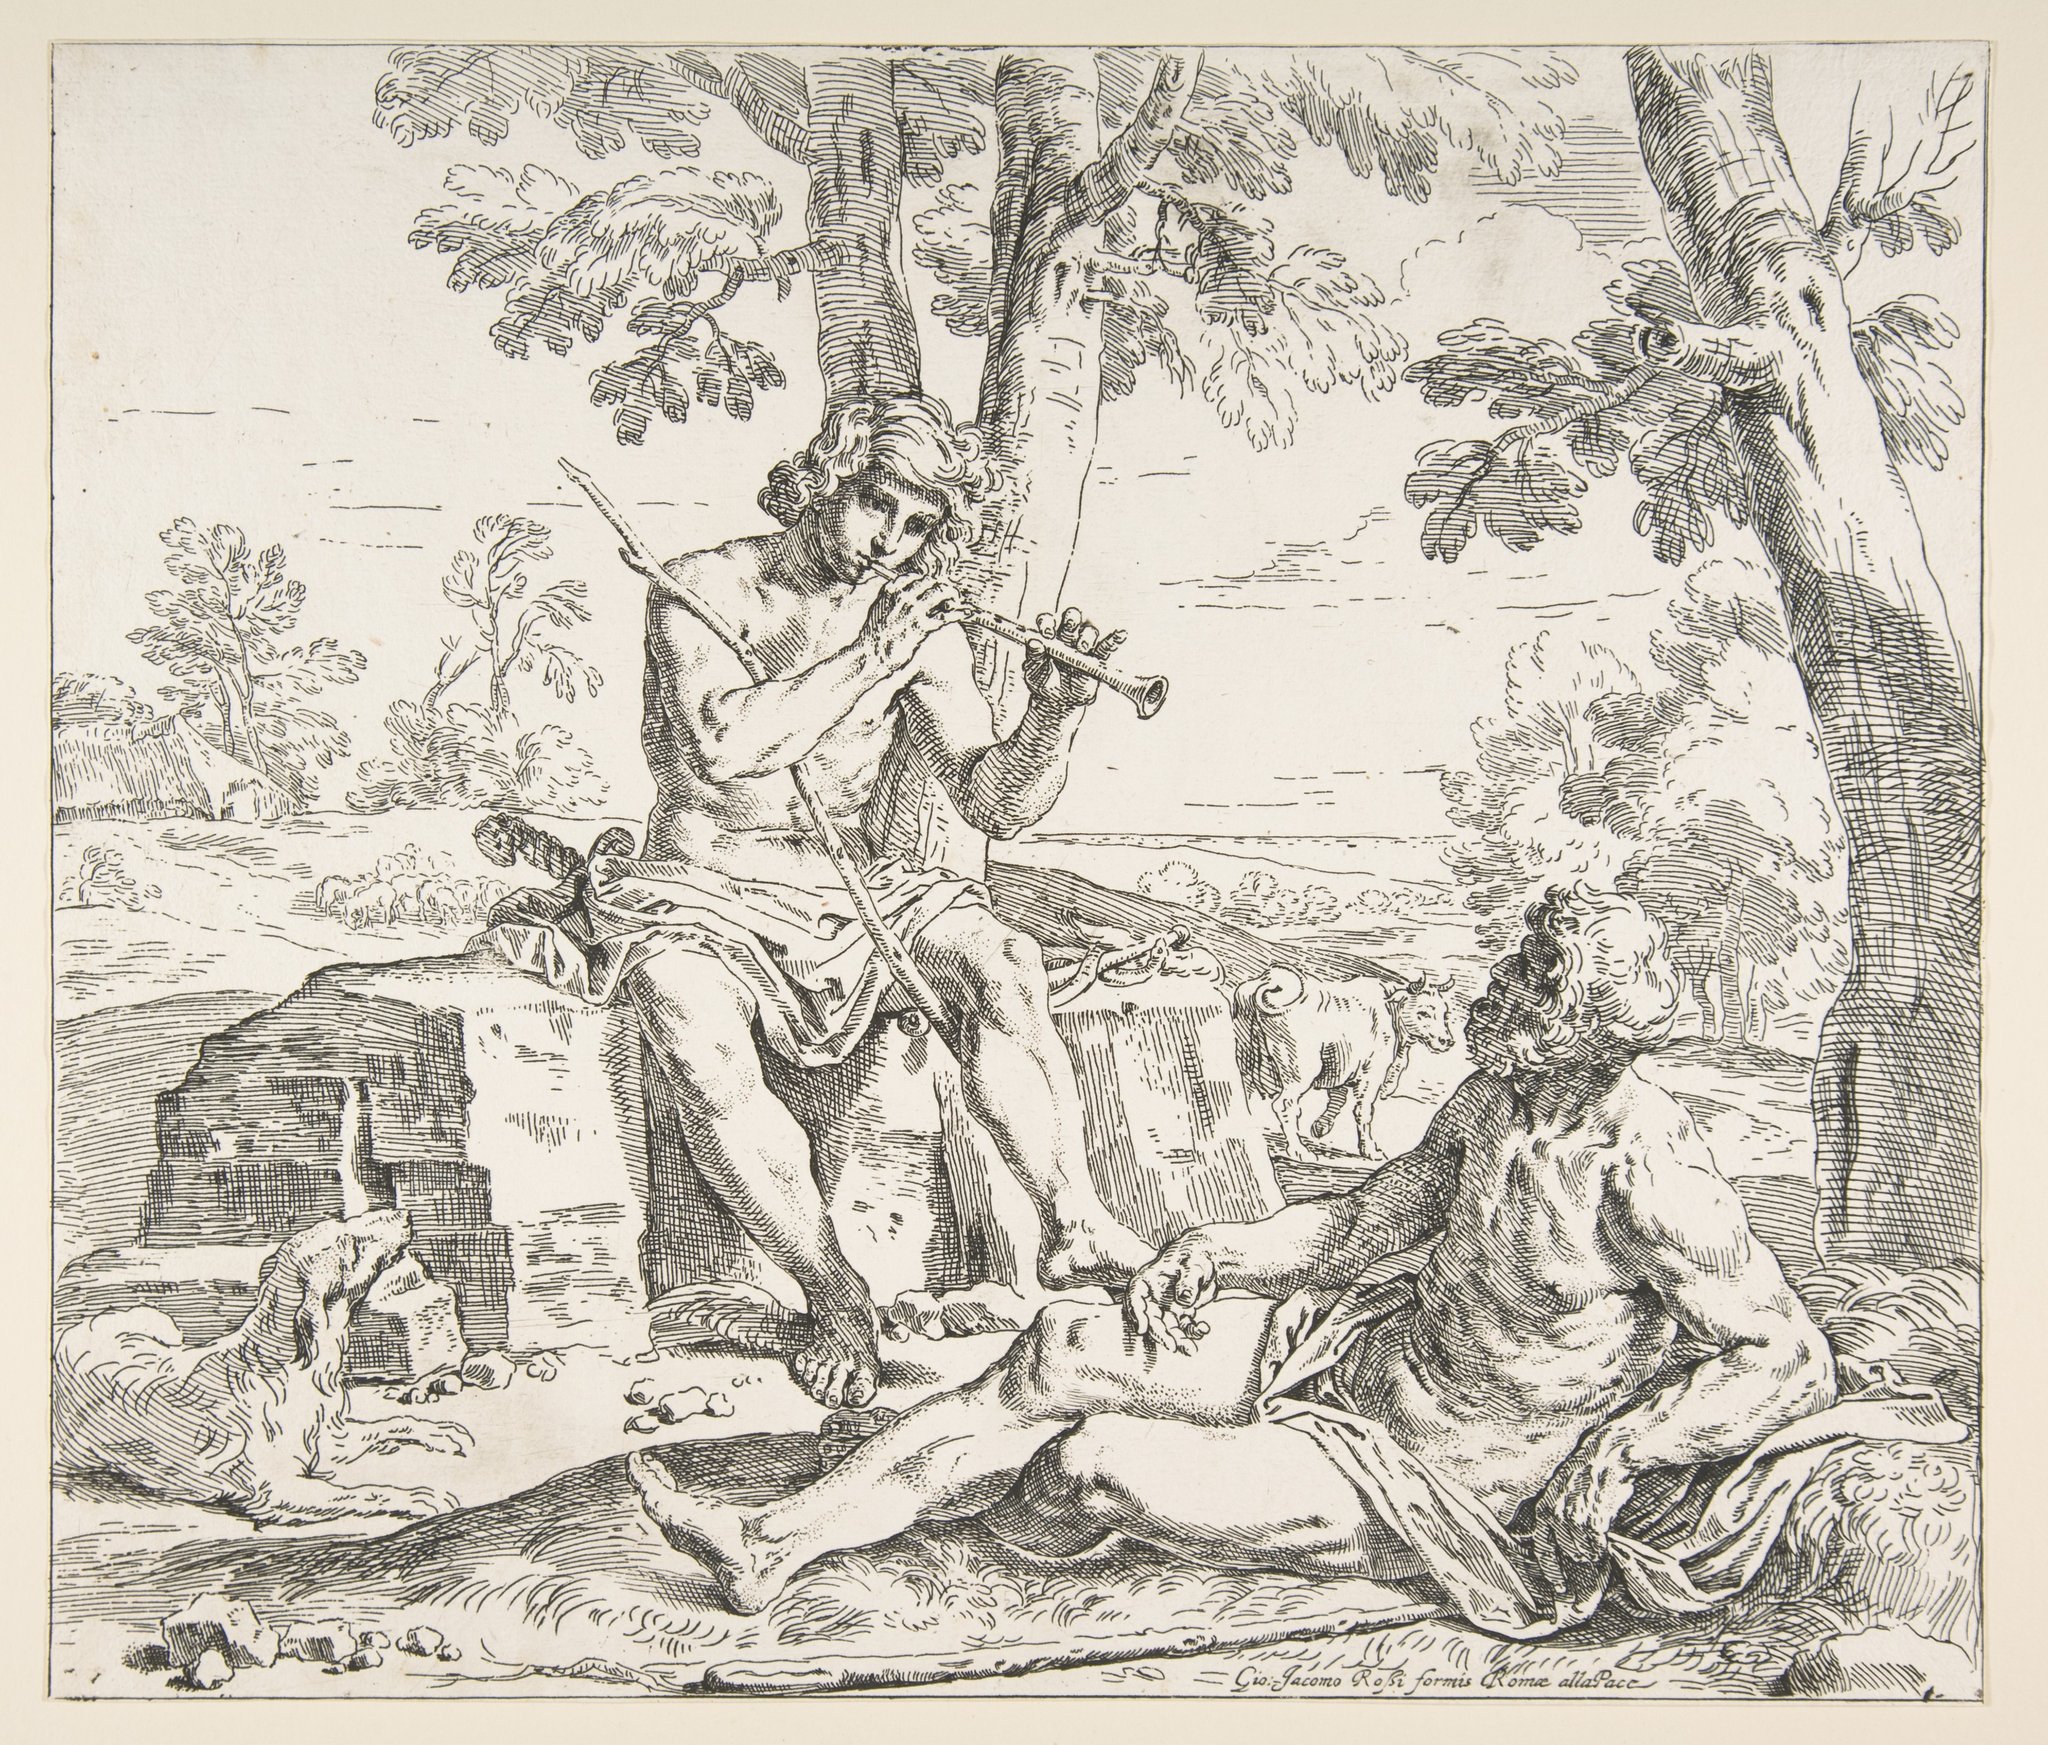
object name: print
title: Mercury and Argus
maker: simone cantarini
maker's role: artist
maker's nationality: italian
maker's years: 1612-1648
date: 1630-1648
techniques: etching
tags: musical instruments,mercury,cows,dogs,trees